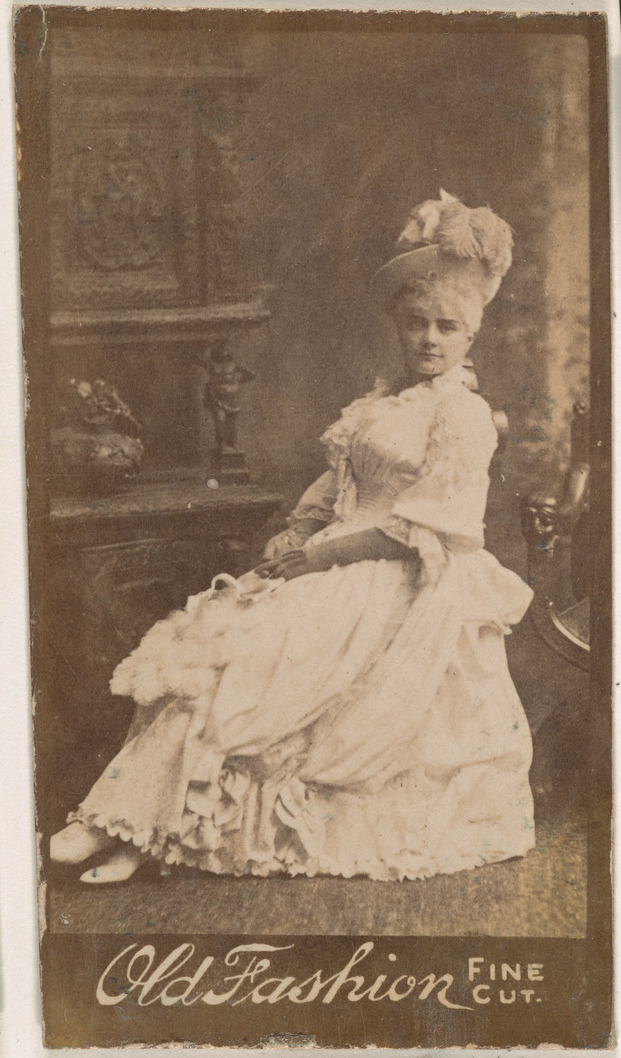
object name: photograph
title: Actress wearing feathered hat, from the Actresses series (N664) promoting Old Fashion Fine Cut Tobacco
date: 1888-1890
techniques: albumen silver print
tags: portraits,women,actresses